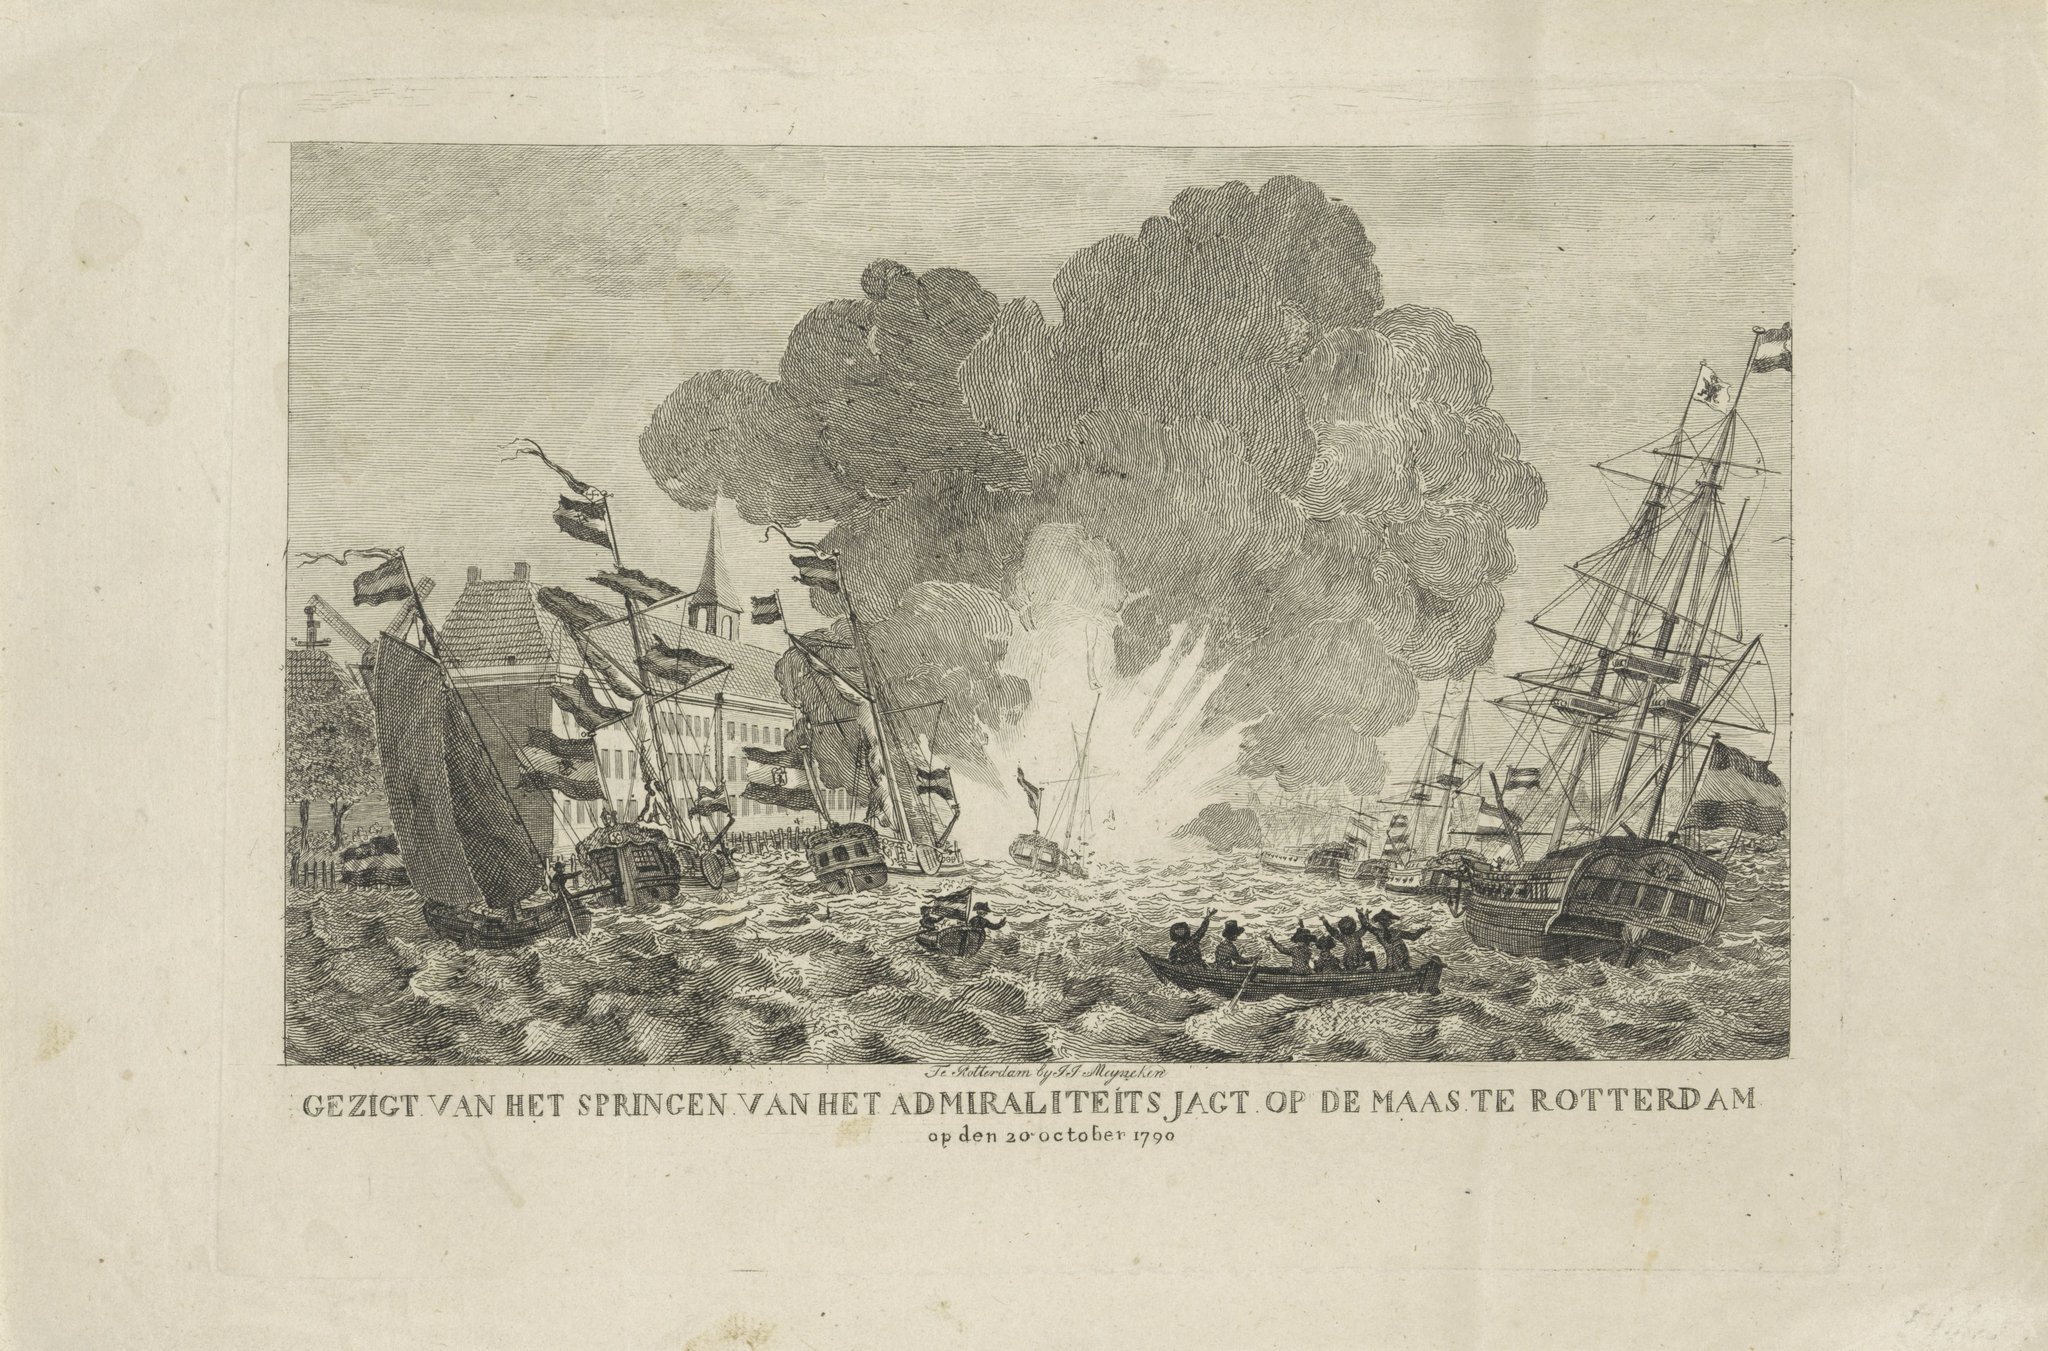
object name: print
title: Gezigt van het springen van het admiraliteits jagt op de Maas te Rotterdam op den 20 october 1790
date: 1701-1791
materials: paper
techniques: engraving, etching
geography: rotterdam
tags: sailing-ship, sailing-boat, gunpowder disaster, rotterdam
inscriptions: inscription: ‘J: J: Meyneken’, collector's mark: Lugt 2228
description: Ontploffing van de admiraliteitsjacht op de Maas te Rotterdam, tijdens de feestelijkheden ter ere van de komst van het stadhouderlijk gezin naar Rotterdam, 20 maart 1790. Links het gebouw van de Admiraliteit op de Maze.